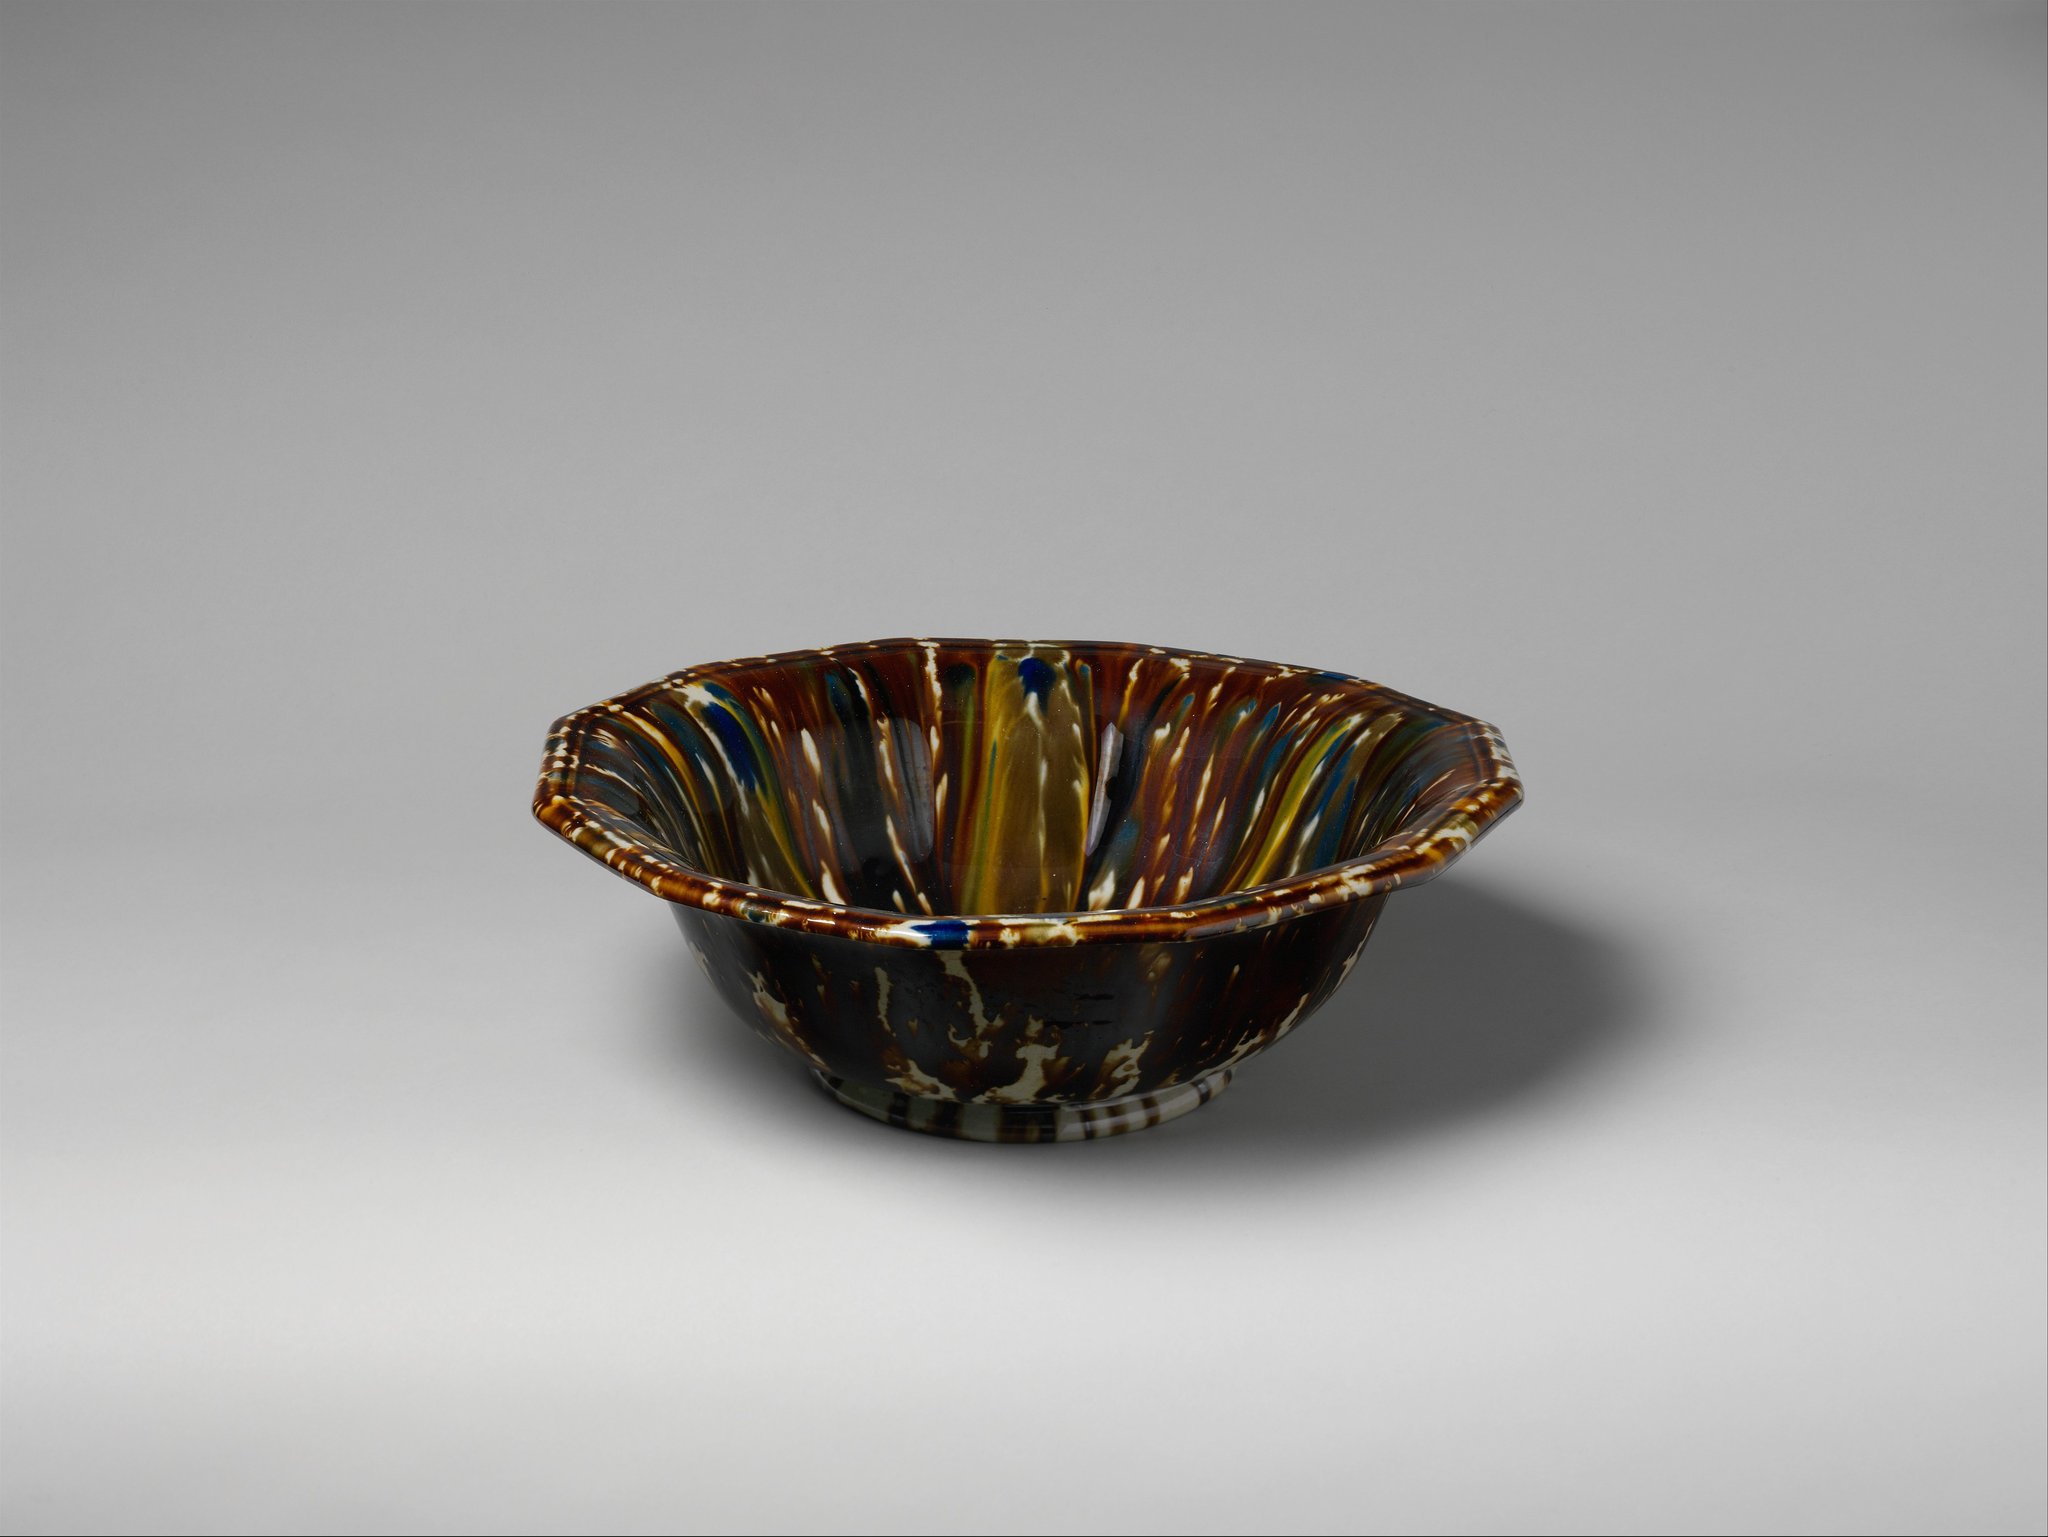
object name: basin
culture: american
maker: lyman, fenton & co.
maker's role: maker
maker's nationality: american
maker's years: 1849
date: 1849-1858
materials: earthenware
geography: united states